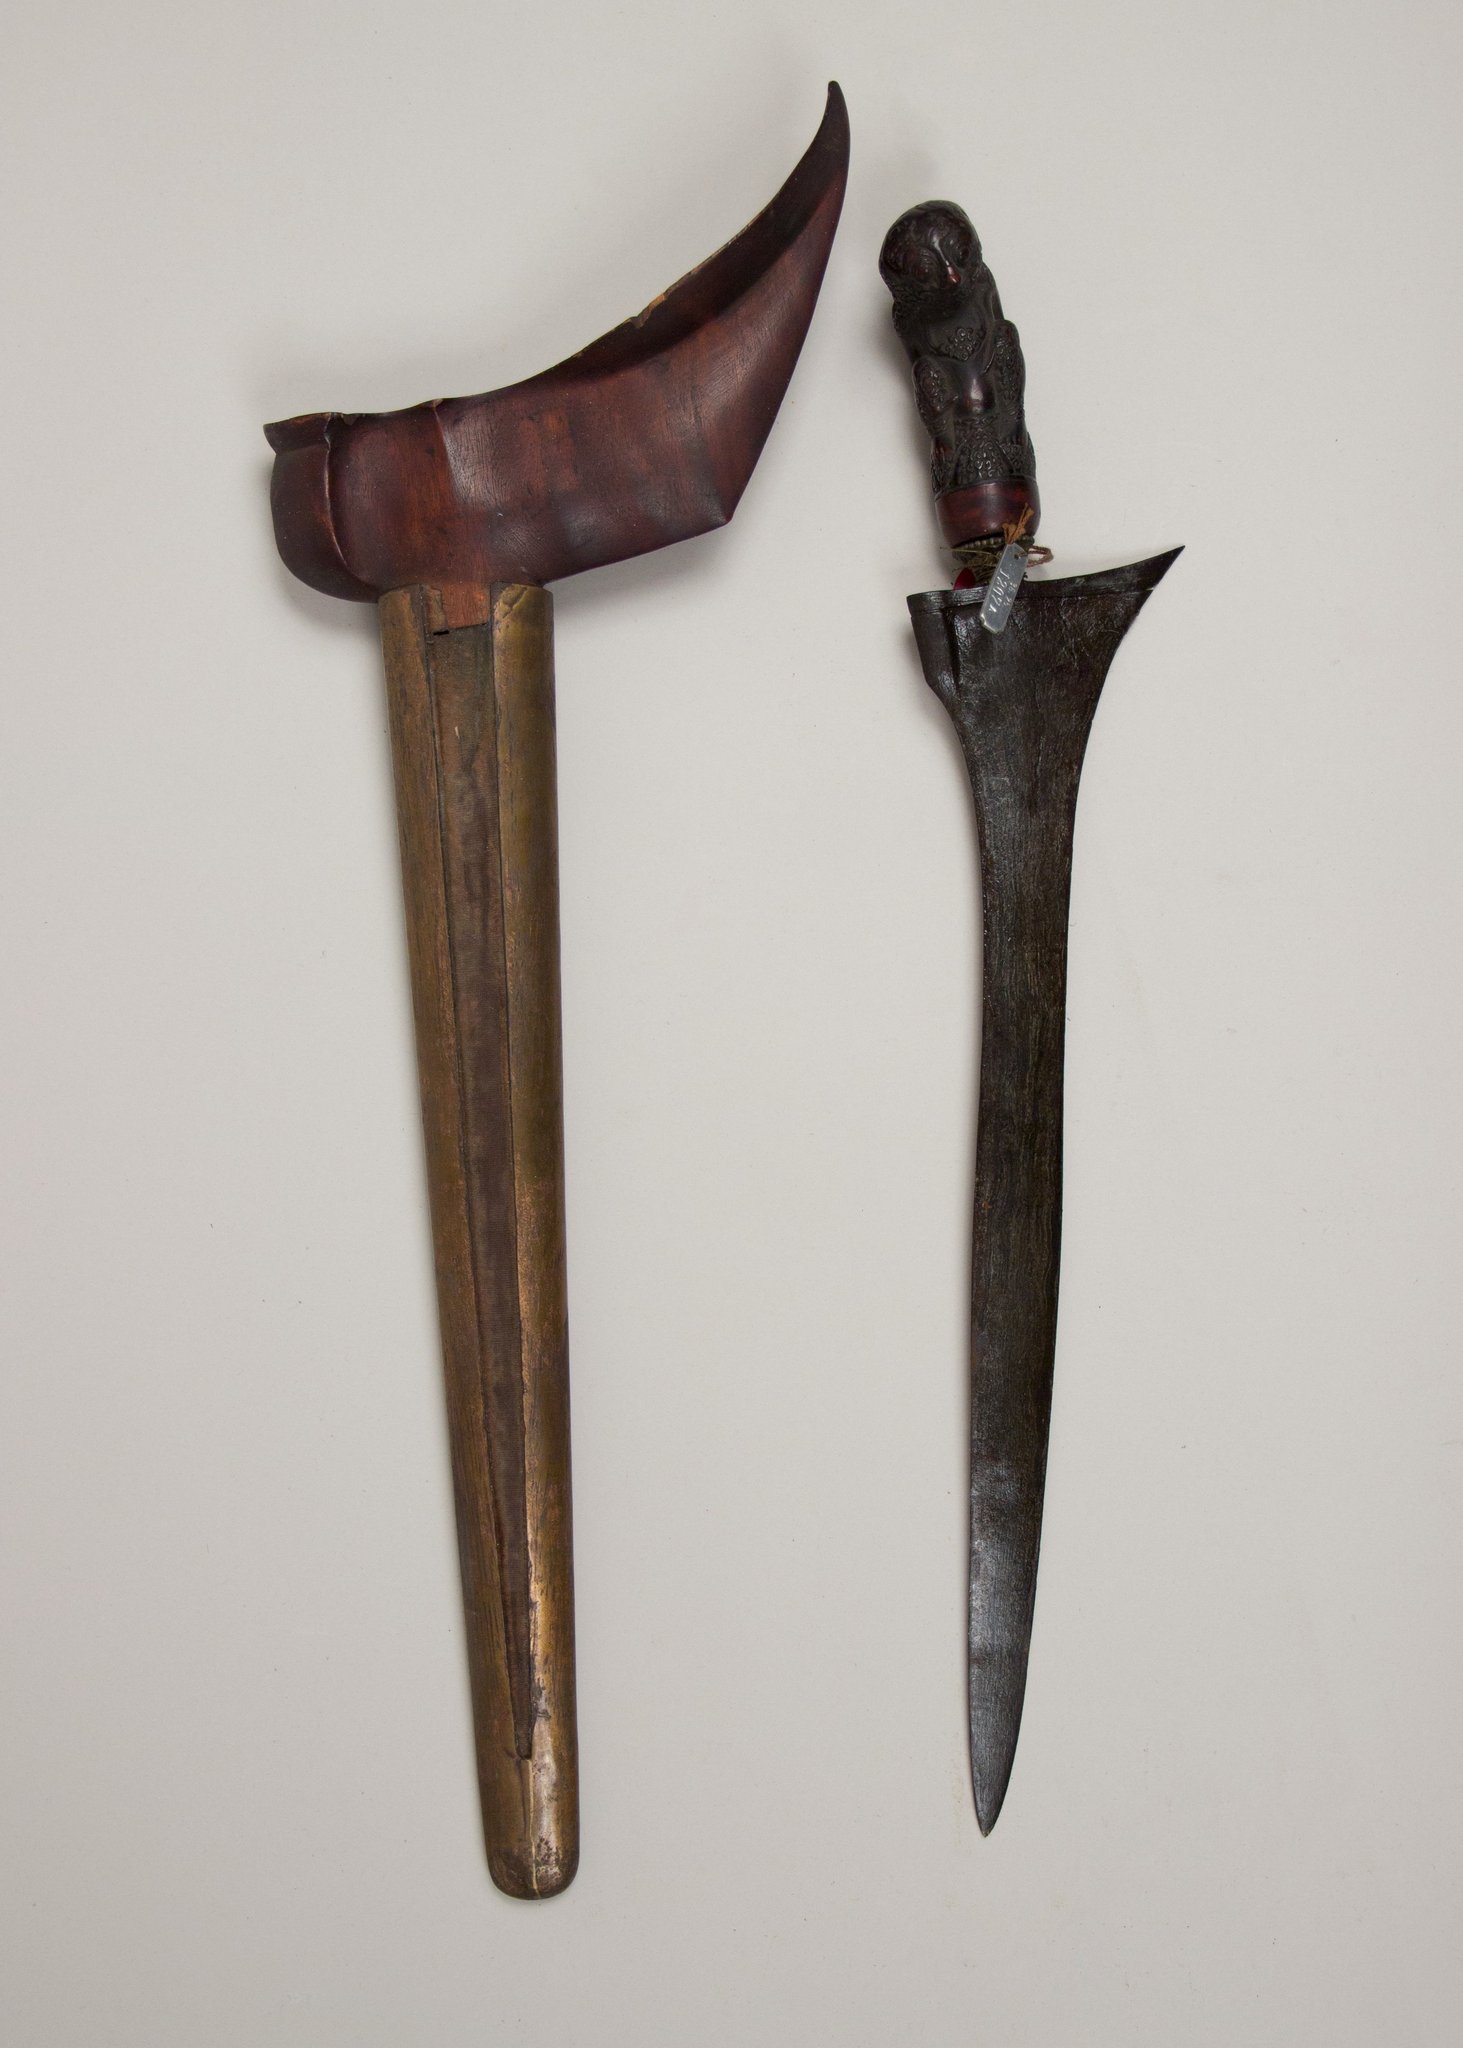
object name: kris with sheath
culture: javanese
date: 1501-1900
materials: brass, velvet, wood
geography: indonesia